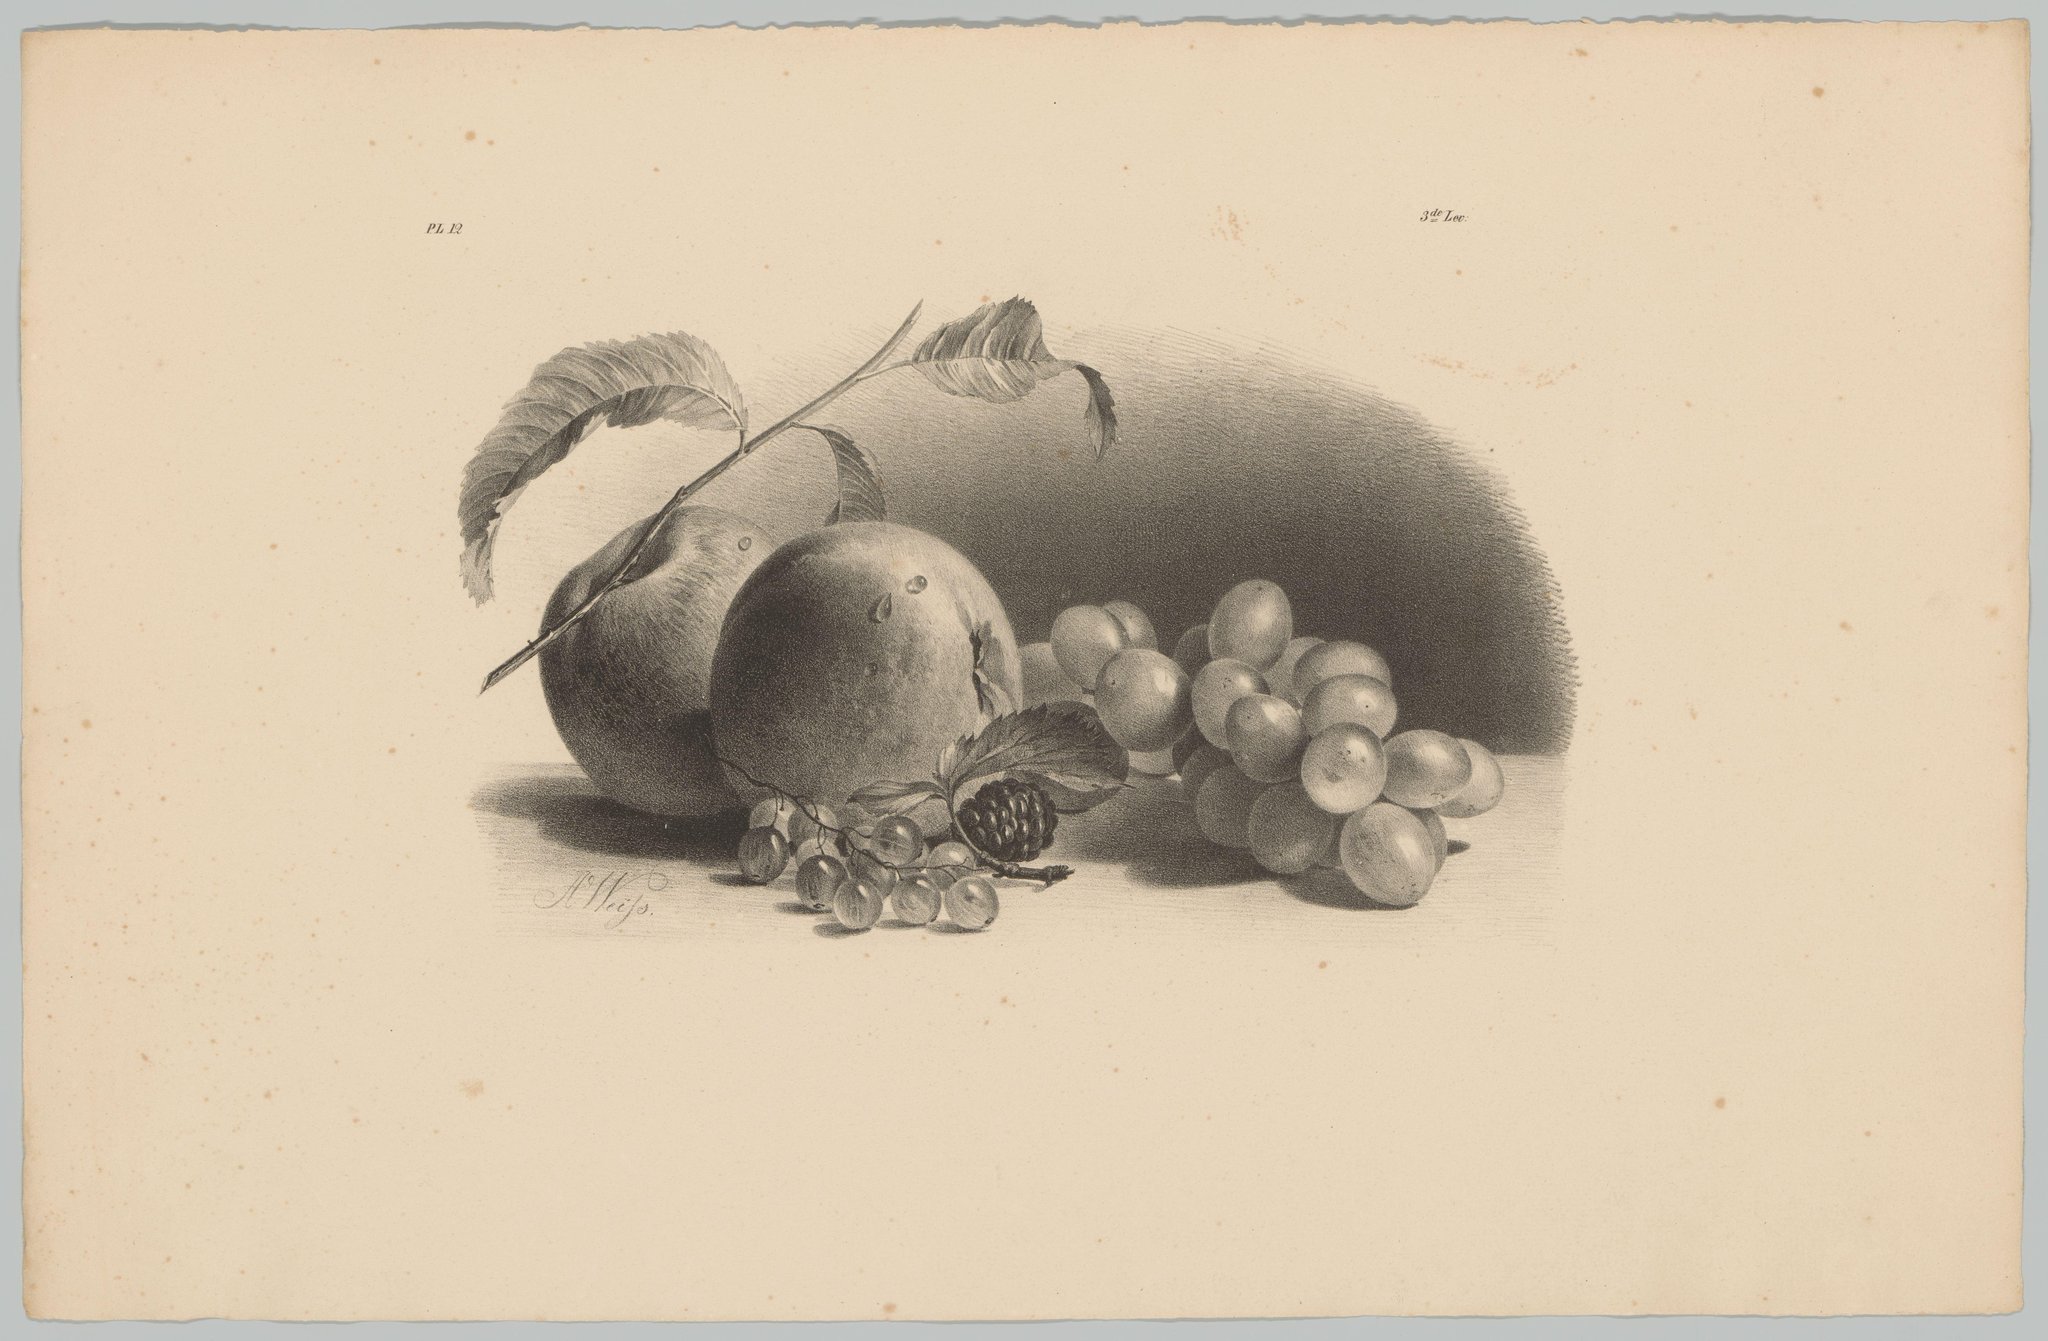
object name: print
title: Bloem en Fruit Studien (...) 3de aflevering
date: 1820-1833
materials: paper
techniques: lithograph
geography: amsterdam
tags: fruits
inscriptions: collector's mark: Lugt 2228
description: Rechts boven genummerd 3de Lev. Onderdeel van een omslag met in totaal zevenenzeventig lithografieën van bloemen en fruit.